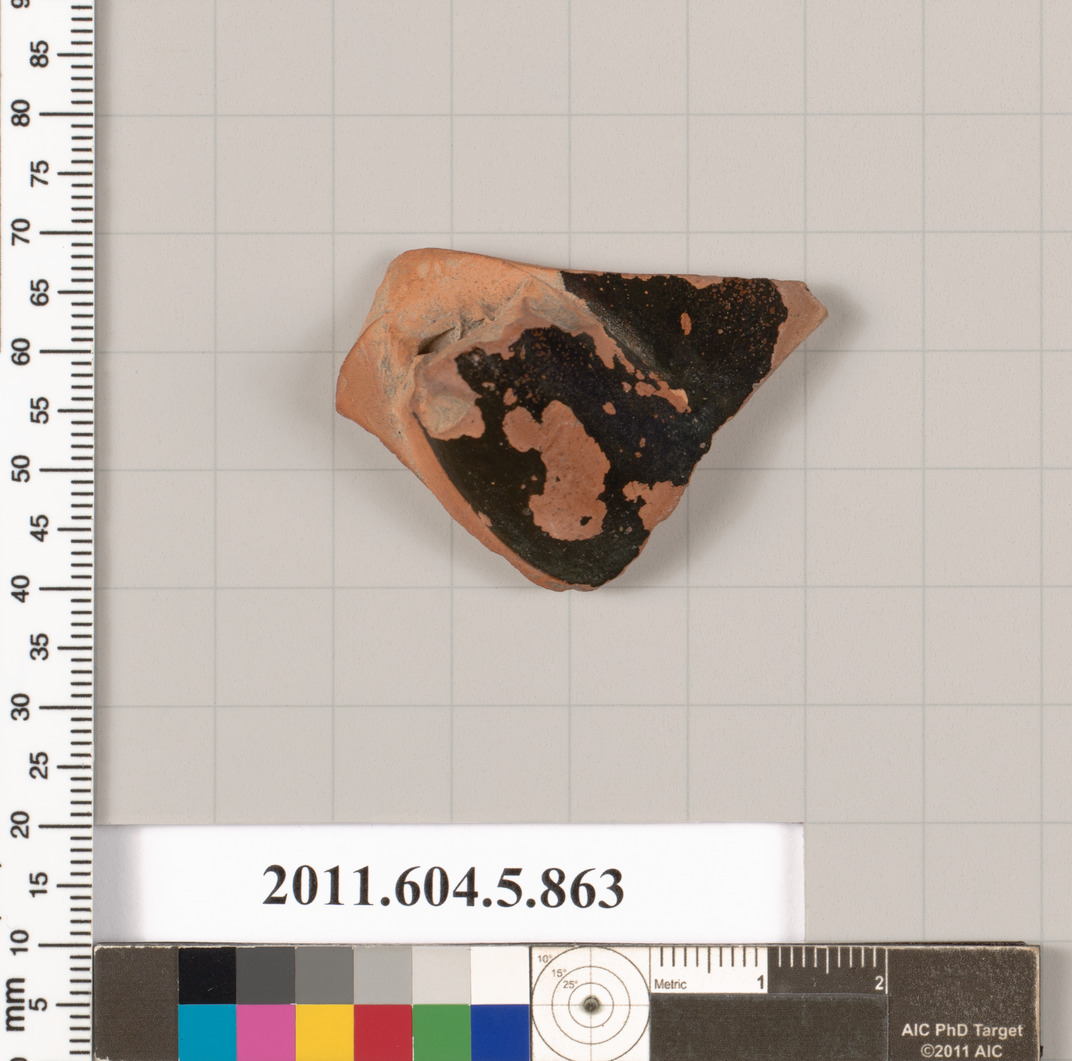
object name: kylix fragment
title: Terracotta fragment of a kylix (drinking cup)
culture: greek, attic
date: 600-401 BCE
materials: terracotta